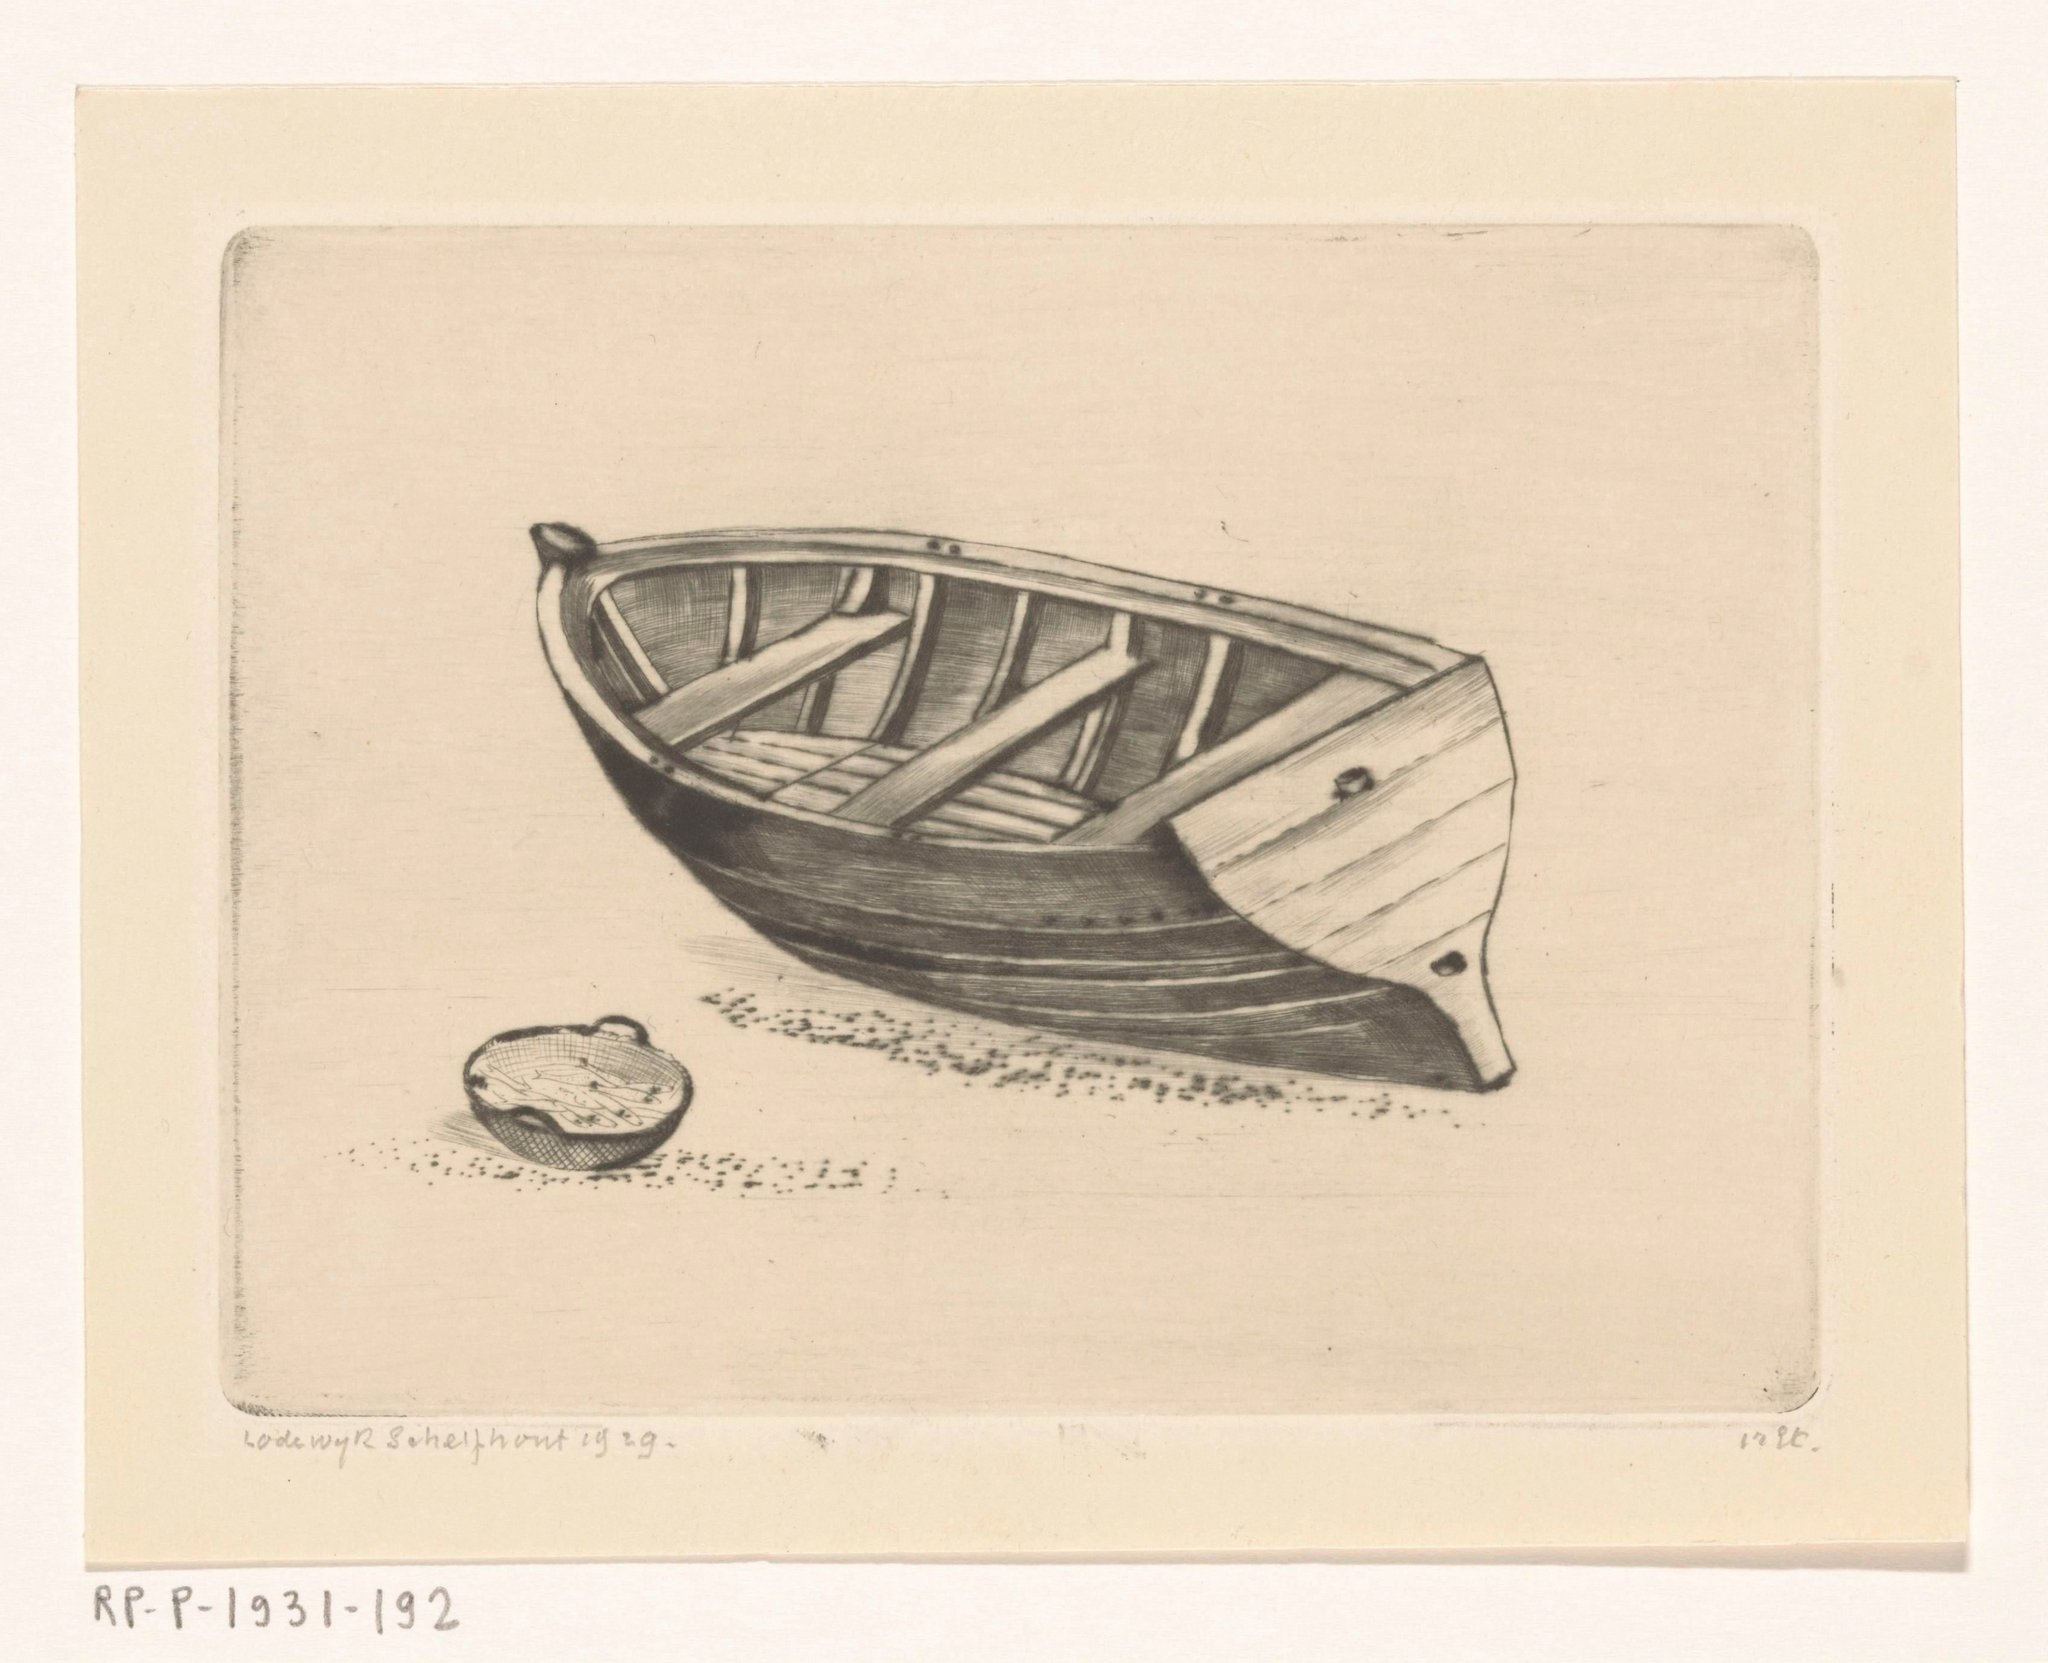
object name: print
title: Sloep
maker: lodewijk schelfhout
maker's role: draughtsman, print maker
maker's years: 1881-1943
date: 1929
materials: paper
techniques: drypoint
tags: fishes, container made of plant material other than wood: basket, rowing-boat, canoe, etc.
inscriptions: collector's mark: Lugt 2228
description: Een sloep en een mand met vis op een strand.